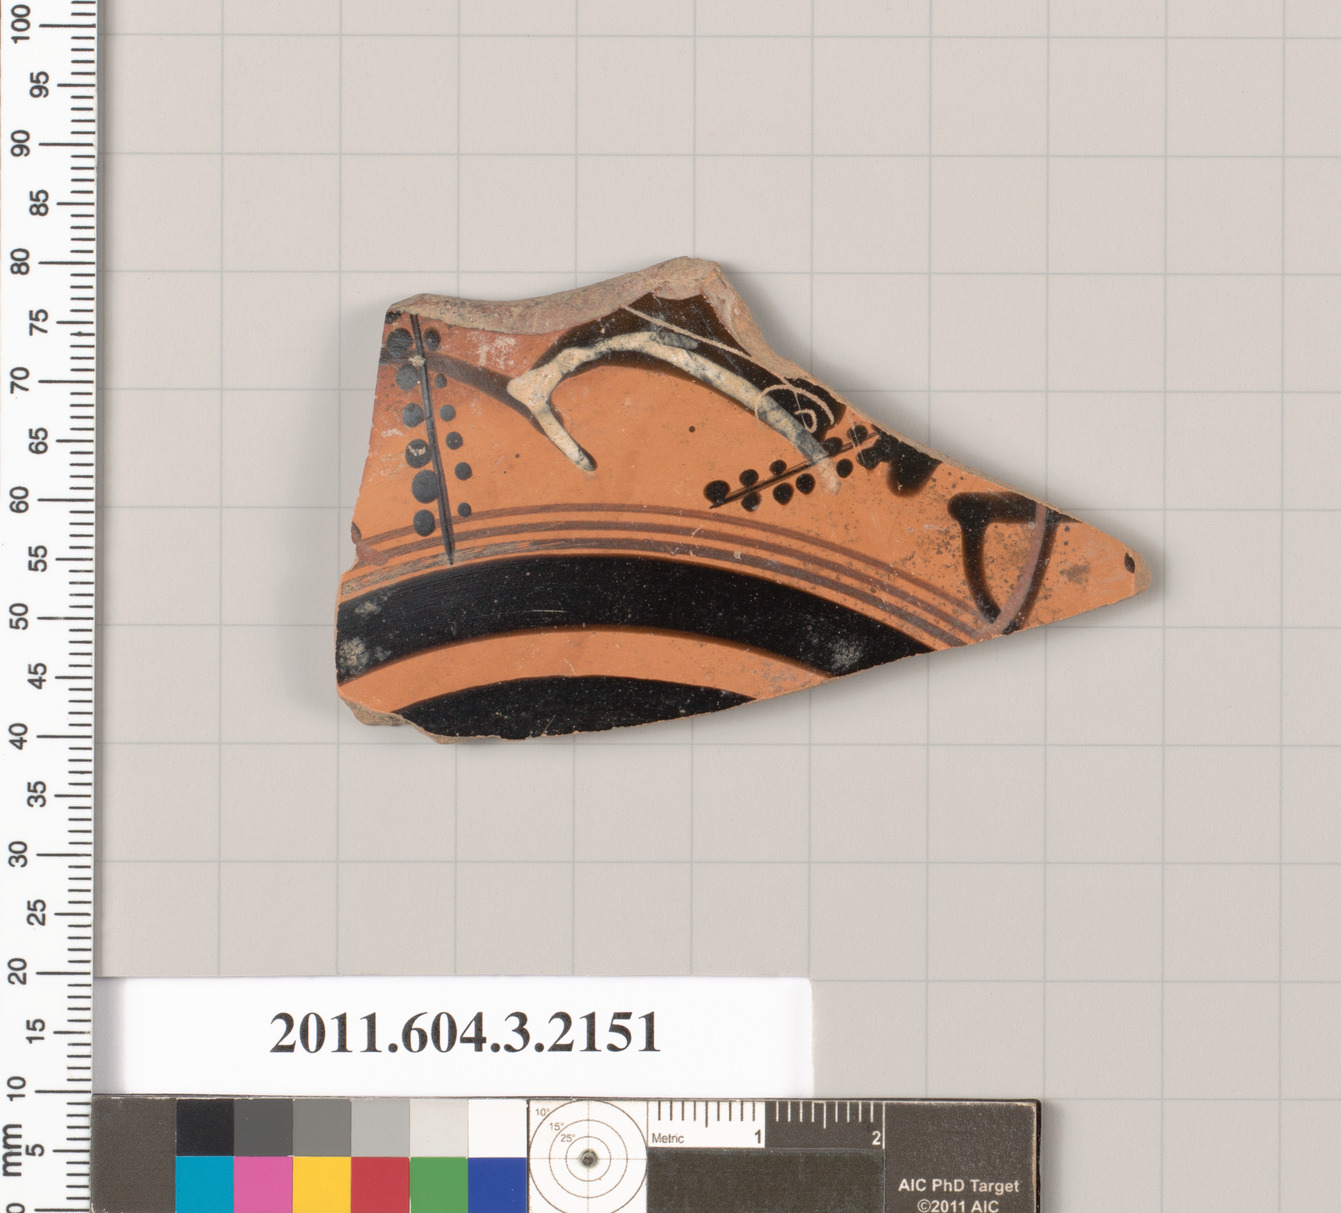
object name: kylix fragment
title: Terracotta fragment of a kylix (drinking cup)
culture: greek, attic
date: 525-501 BCE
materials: terracotta